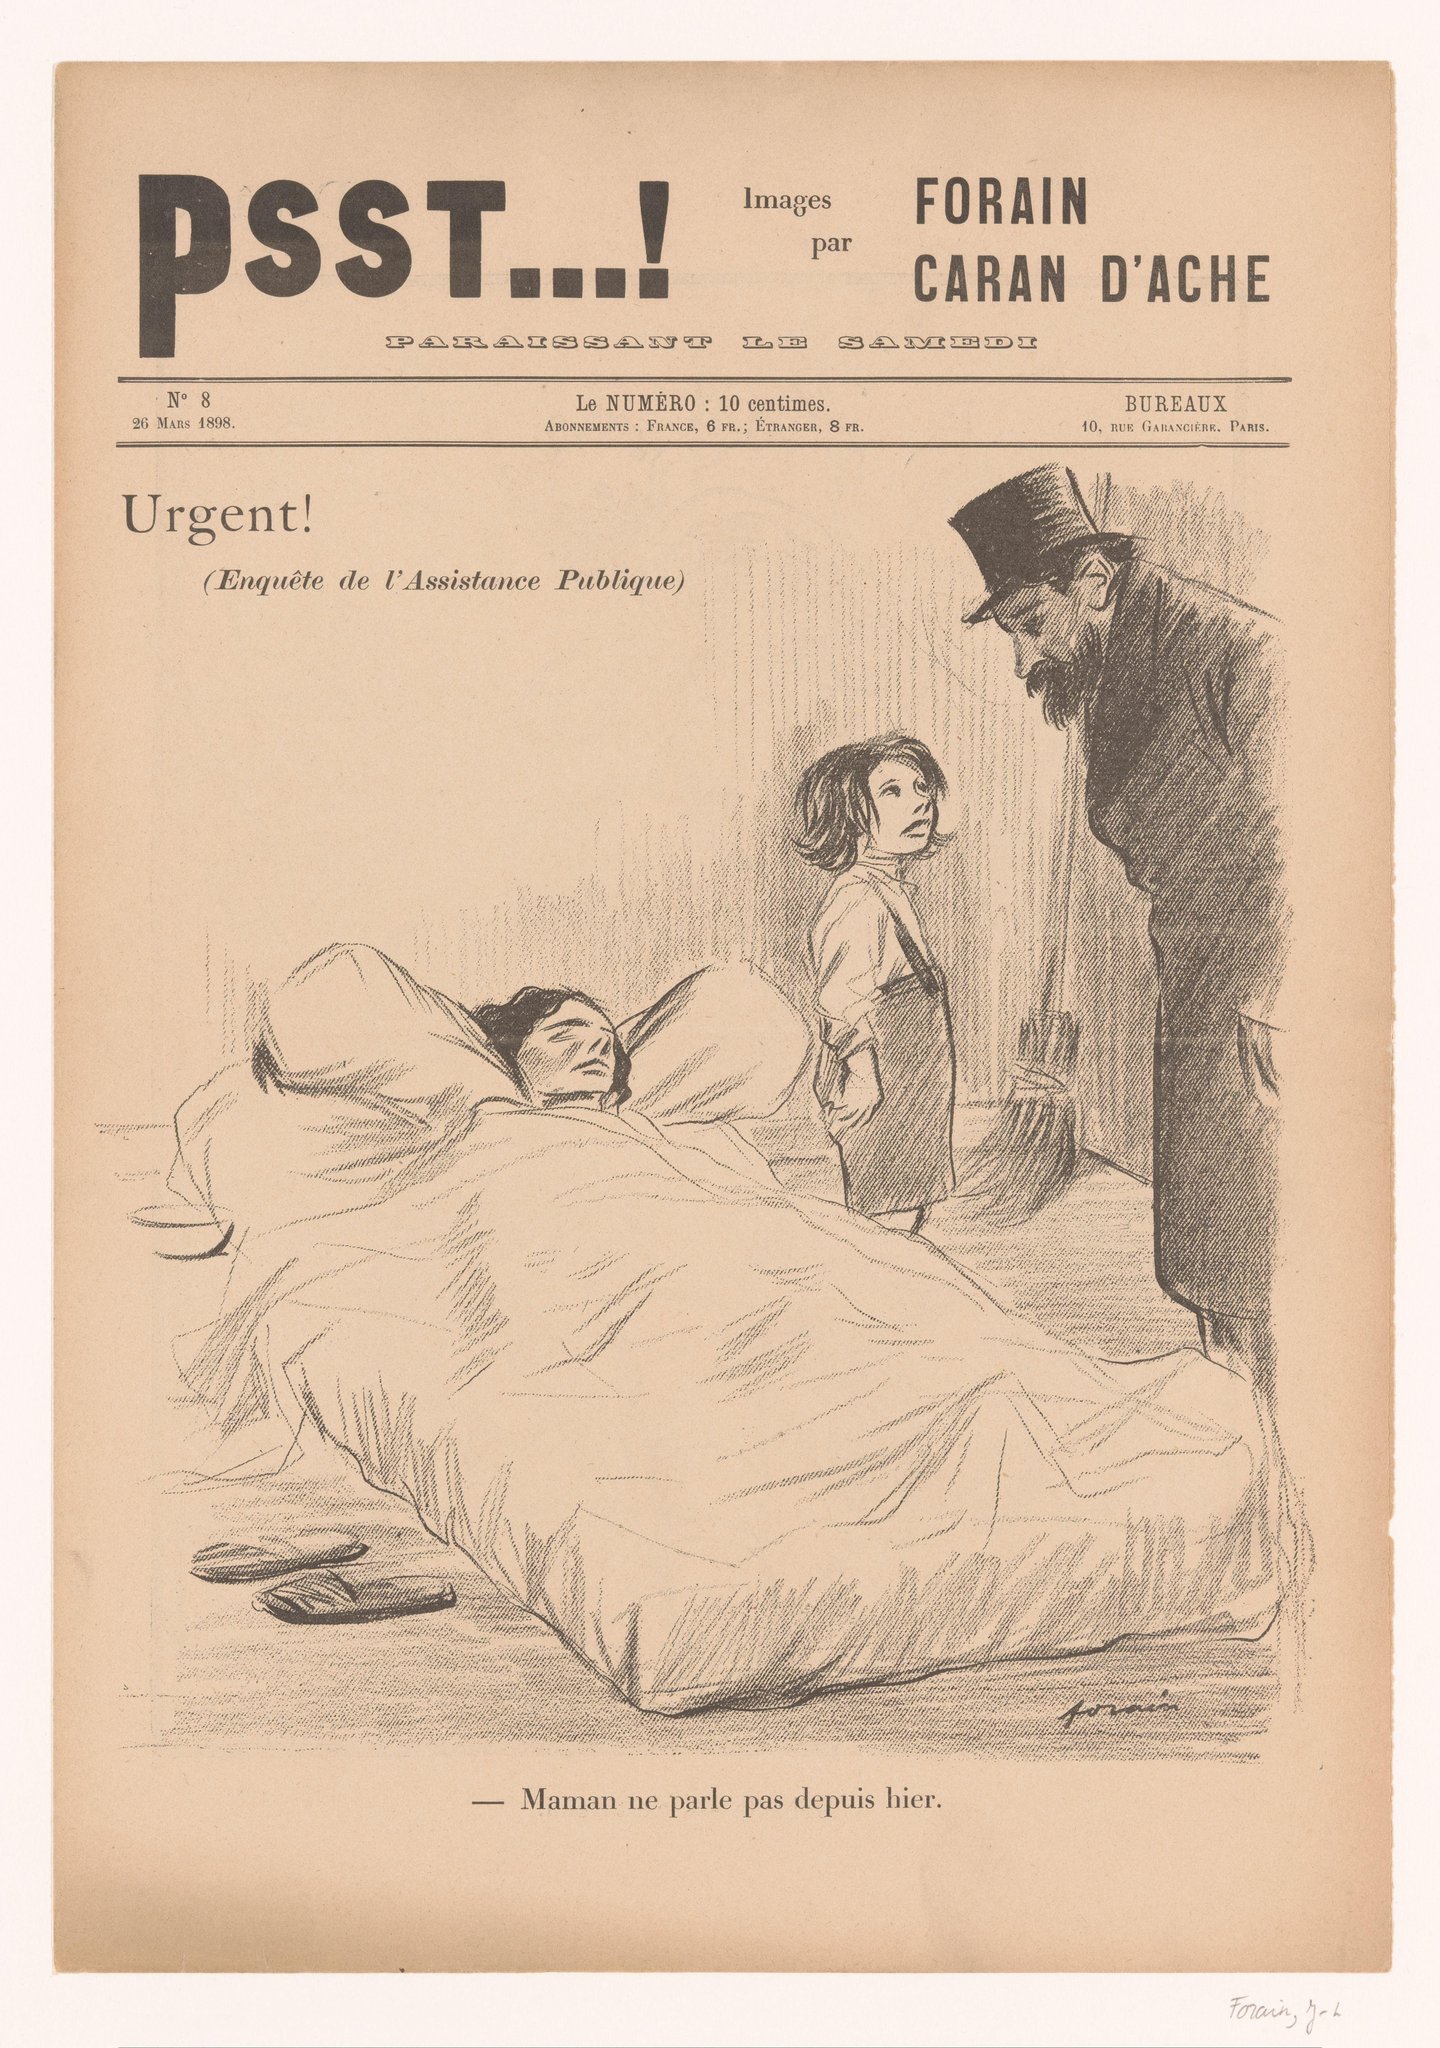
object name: cartoon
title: Man keert terug bij zijn zieke vrouw en kind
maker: jean-louis forain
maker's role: painter, print maker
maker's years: 1852-1931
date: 1898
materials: paper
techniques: lithograph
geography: paris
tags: sick-bed, political caricatures and satires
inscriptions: date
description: Prent gebruikt voor: Psst...!, nr. 8, 26 maart 1898. Psst..! was een politieke weekkrant met antisemitische en anti-Dreyfus cartoons.